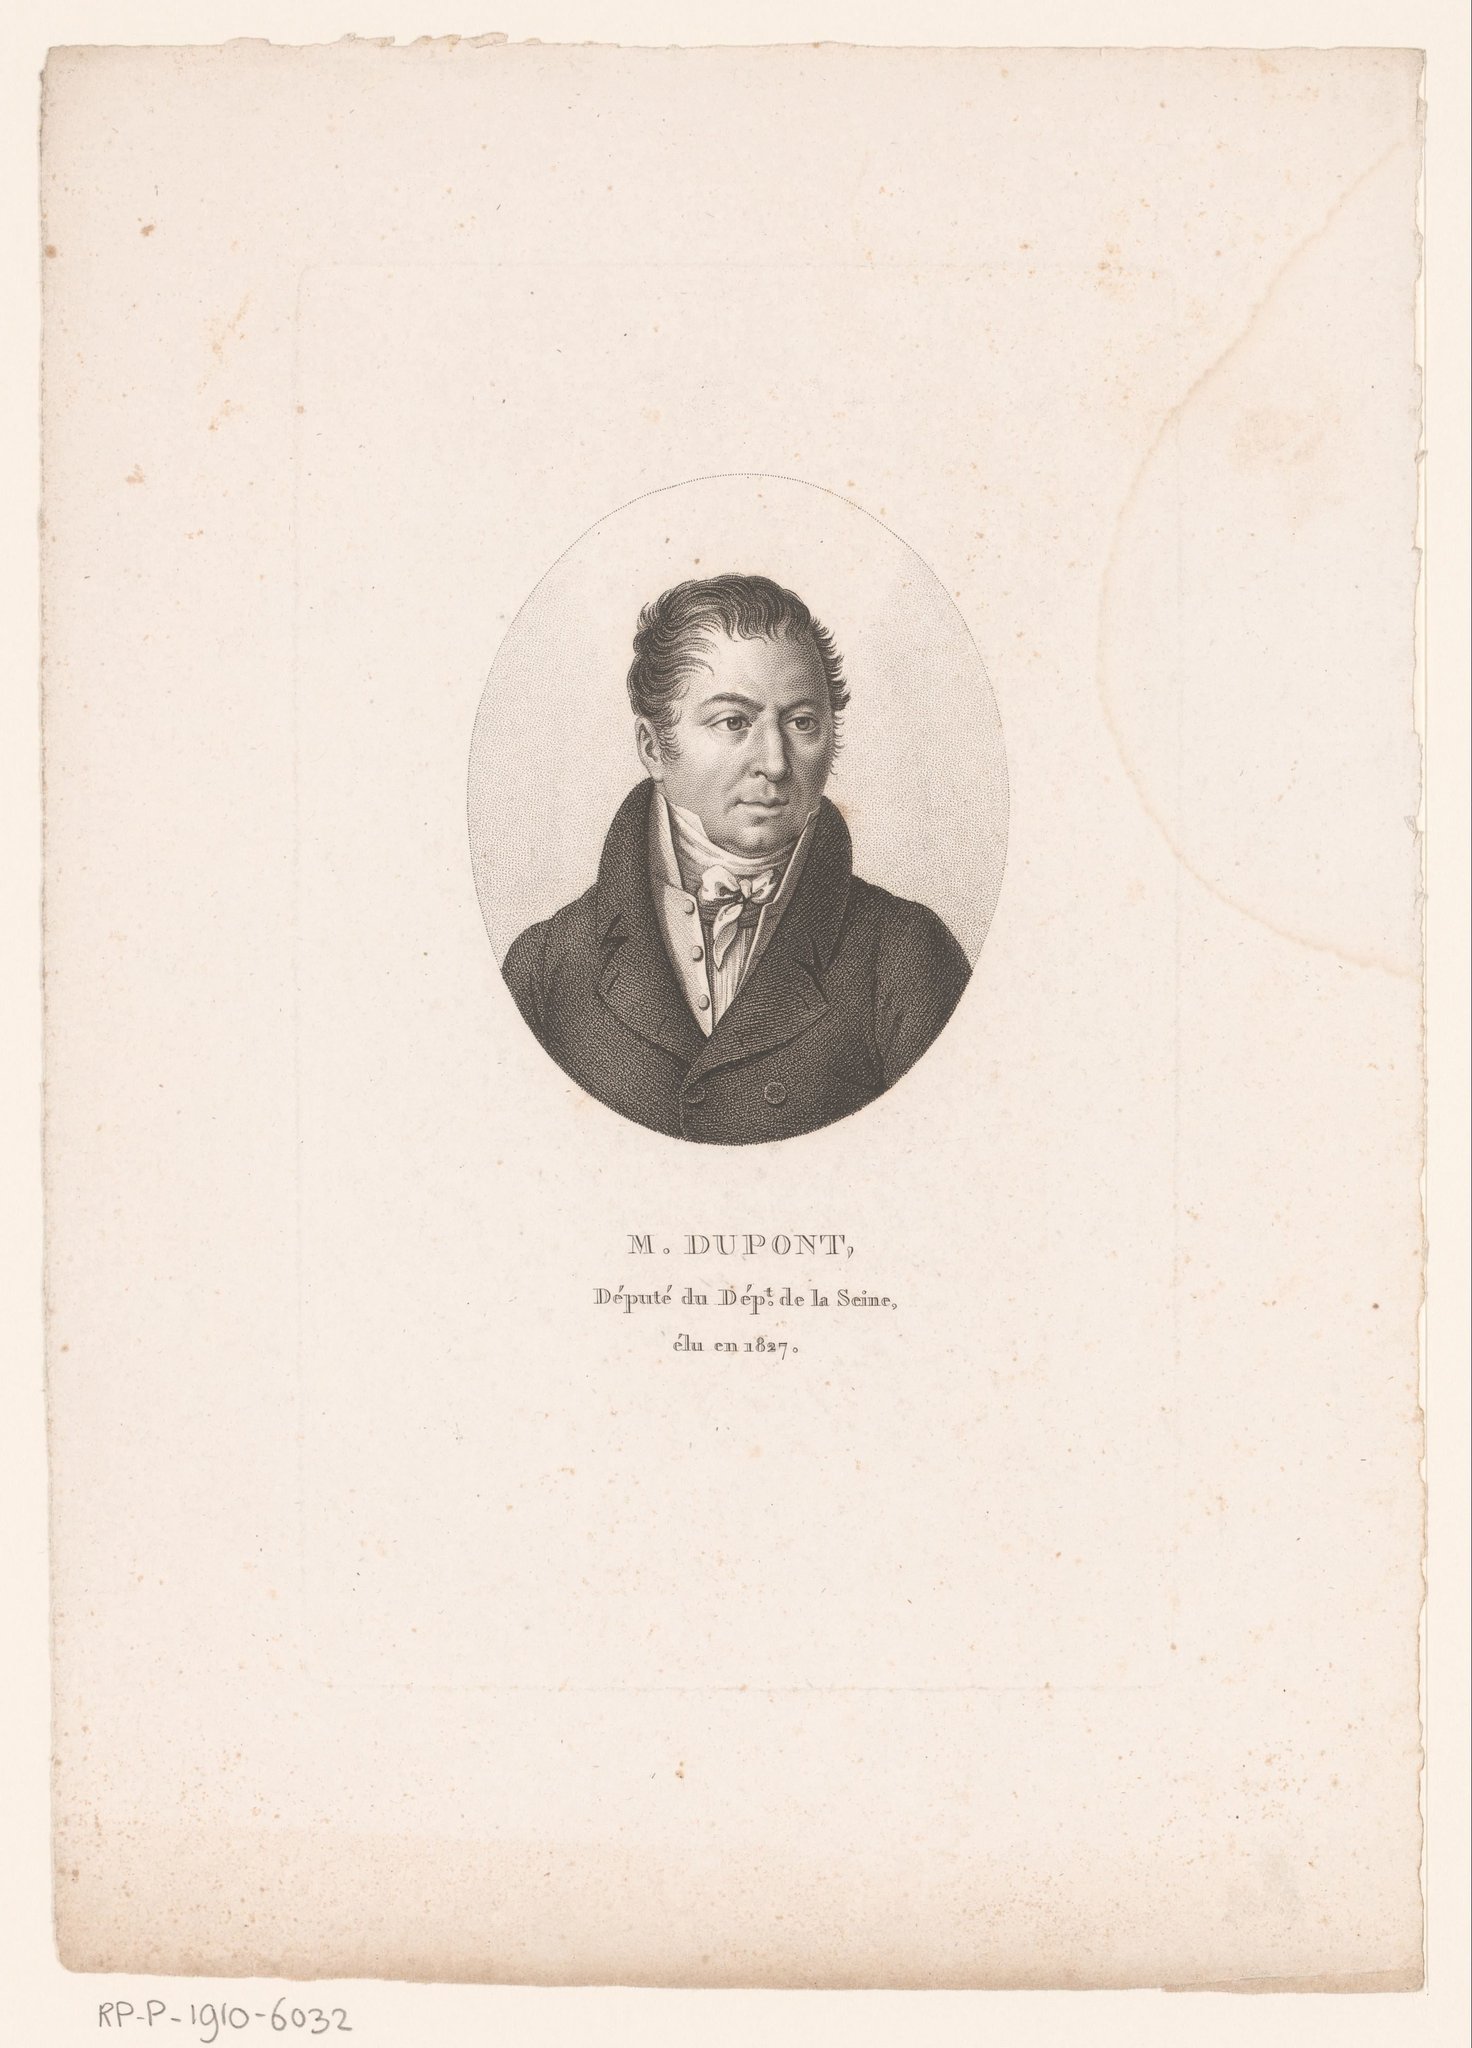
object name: book illustration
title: Portret van Jacques Charles Dupont de l'Eure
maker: ambroise tardieu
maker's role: print maker, printer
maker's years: 1788-1841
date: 1820-1821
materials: paper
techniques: engraving, roulette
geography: paris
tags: politician, historical persons, politician, e.g. party leader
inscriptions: collector's mark: Lugt 2228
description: Prent uit: Tardieu, Ambroise. Portraits des députés, écrivains et pairs constitutionnels, défenseurs invariables de la charte et de la loi des élections du 5 février 1817. Parijs: Tardieu, Ambroise, 1820-1821.